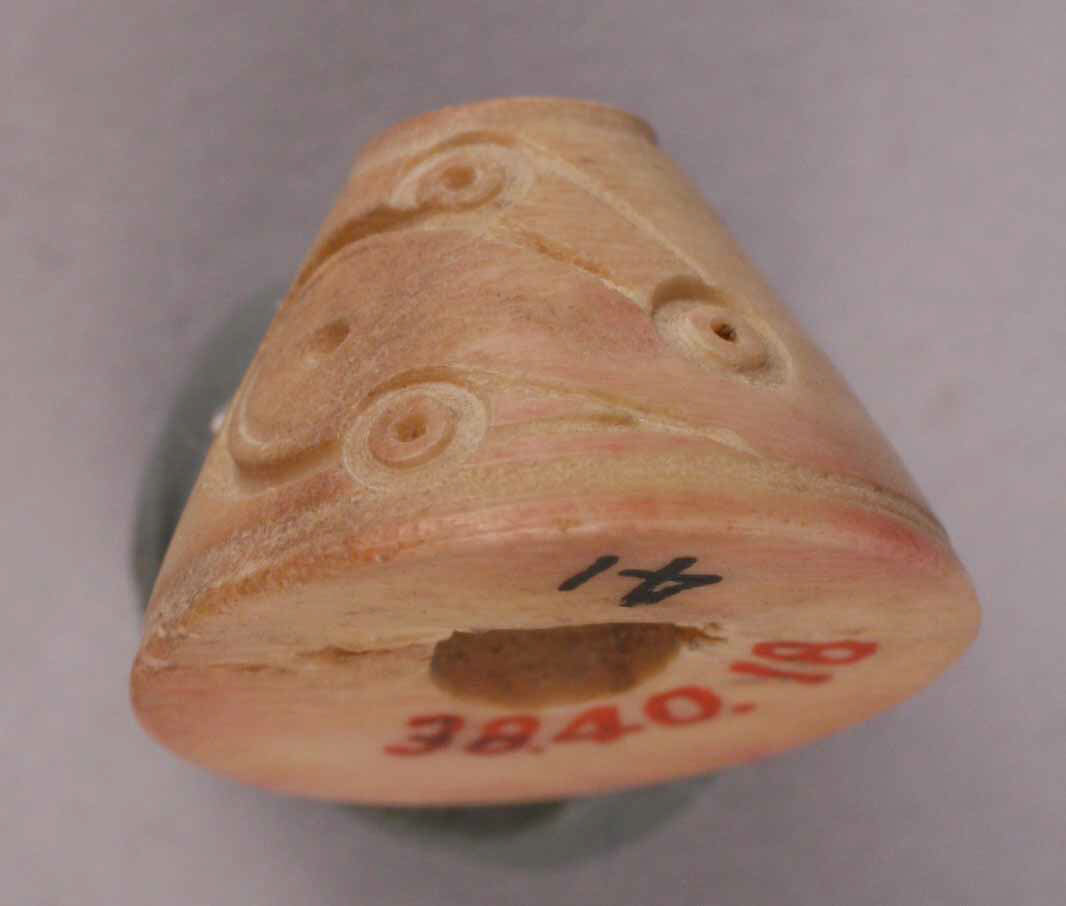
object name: button or bead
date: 801-1000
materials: bone, paint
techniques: incising, inlay, tinting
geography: iran